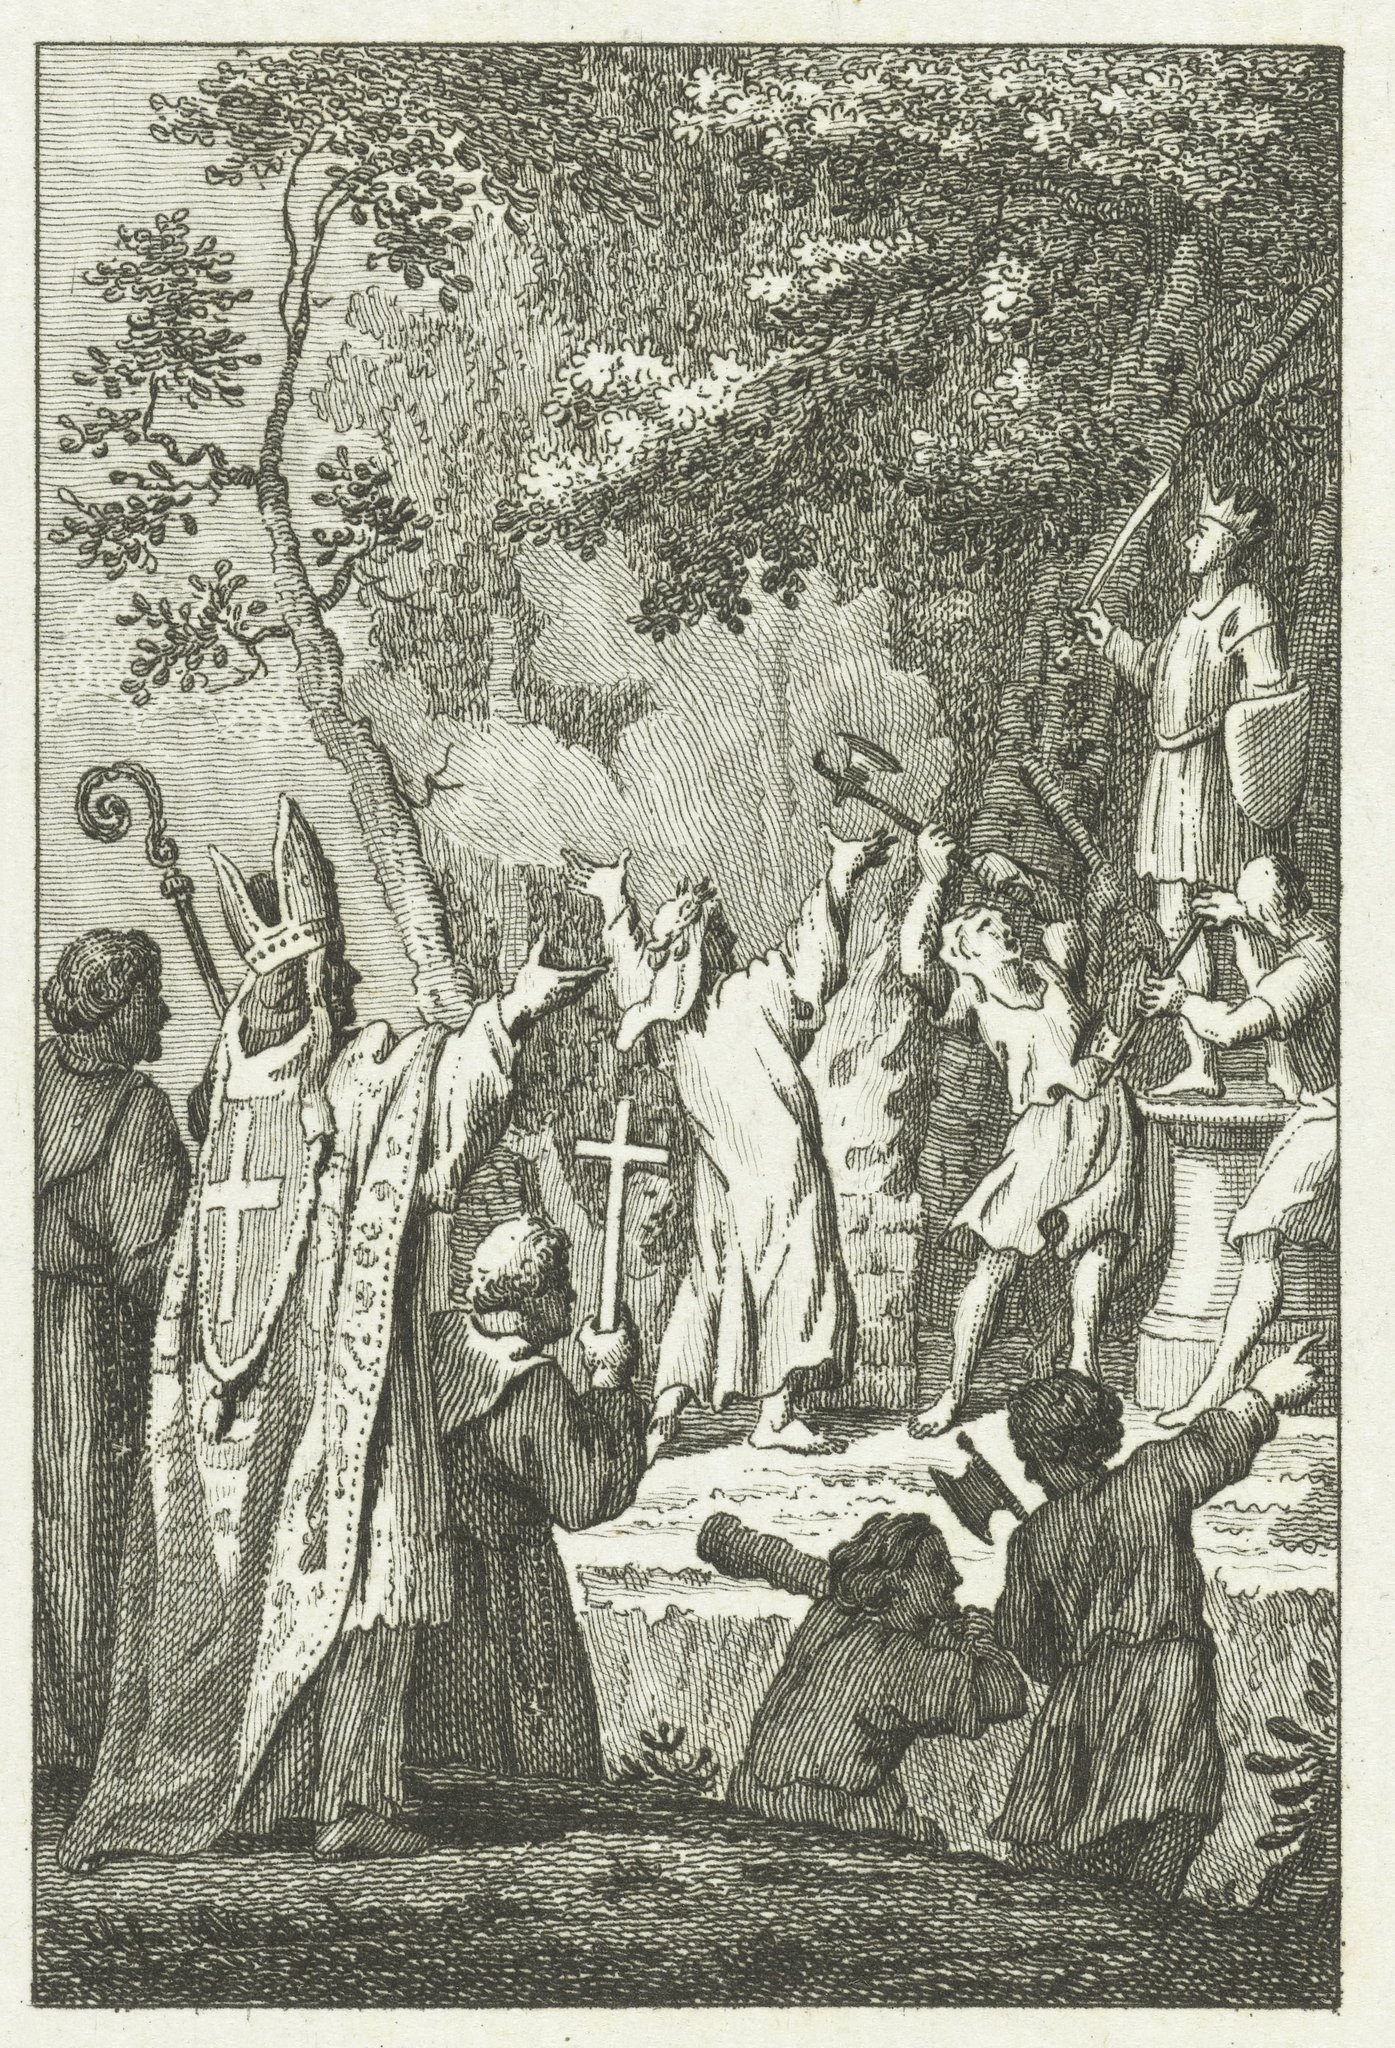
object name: history print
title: Op bevel van Willibrord wordt het beeld van de Germaanse god Wodan te Westkapelle verbrijzeld, 695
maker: reinier vinkeles (i)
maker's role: draughtsman, print maker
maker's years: 1741-1816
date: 1780-1795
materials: paper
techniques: etching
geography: netherlands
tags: destruction of pagan idols, statues, paintings, etc. ~ objects of worship (germanic and scandinavian religions), st. willibrord breaking the pagan idols, spreading the gospel; missionary work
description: Illustratie uit: J. Fokke, Geschiedenissen der Vereenigde Nederlanden voor de vaderlandsche jeugd, Johannes Allart, Amsterdam 1783-1795, 25 delen, dl. I, pl. VIII. Niet in Frederik Muller; door het RPK toegevoegd nummer.